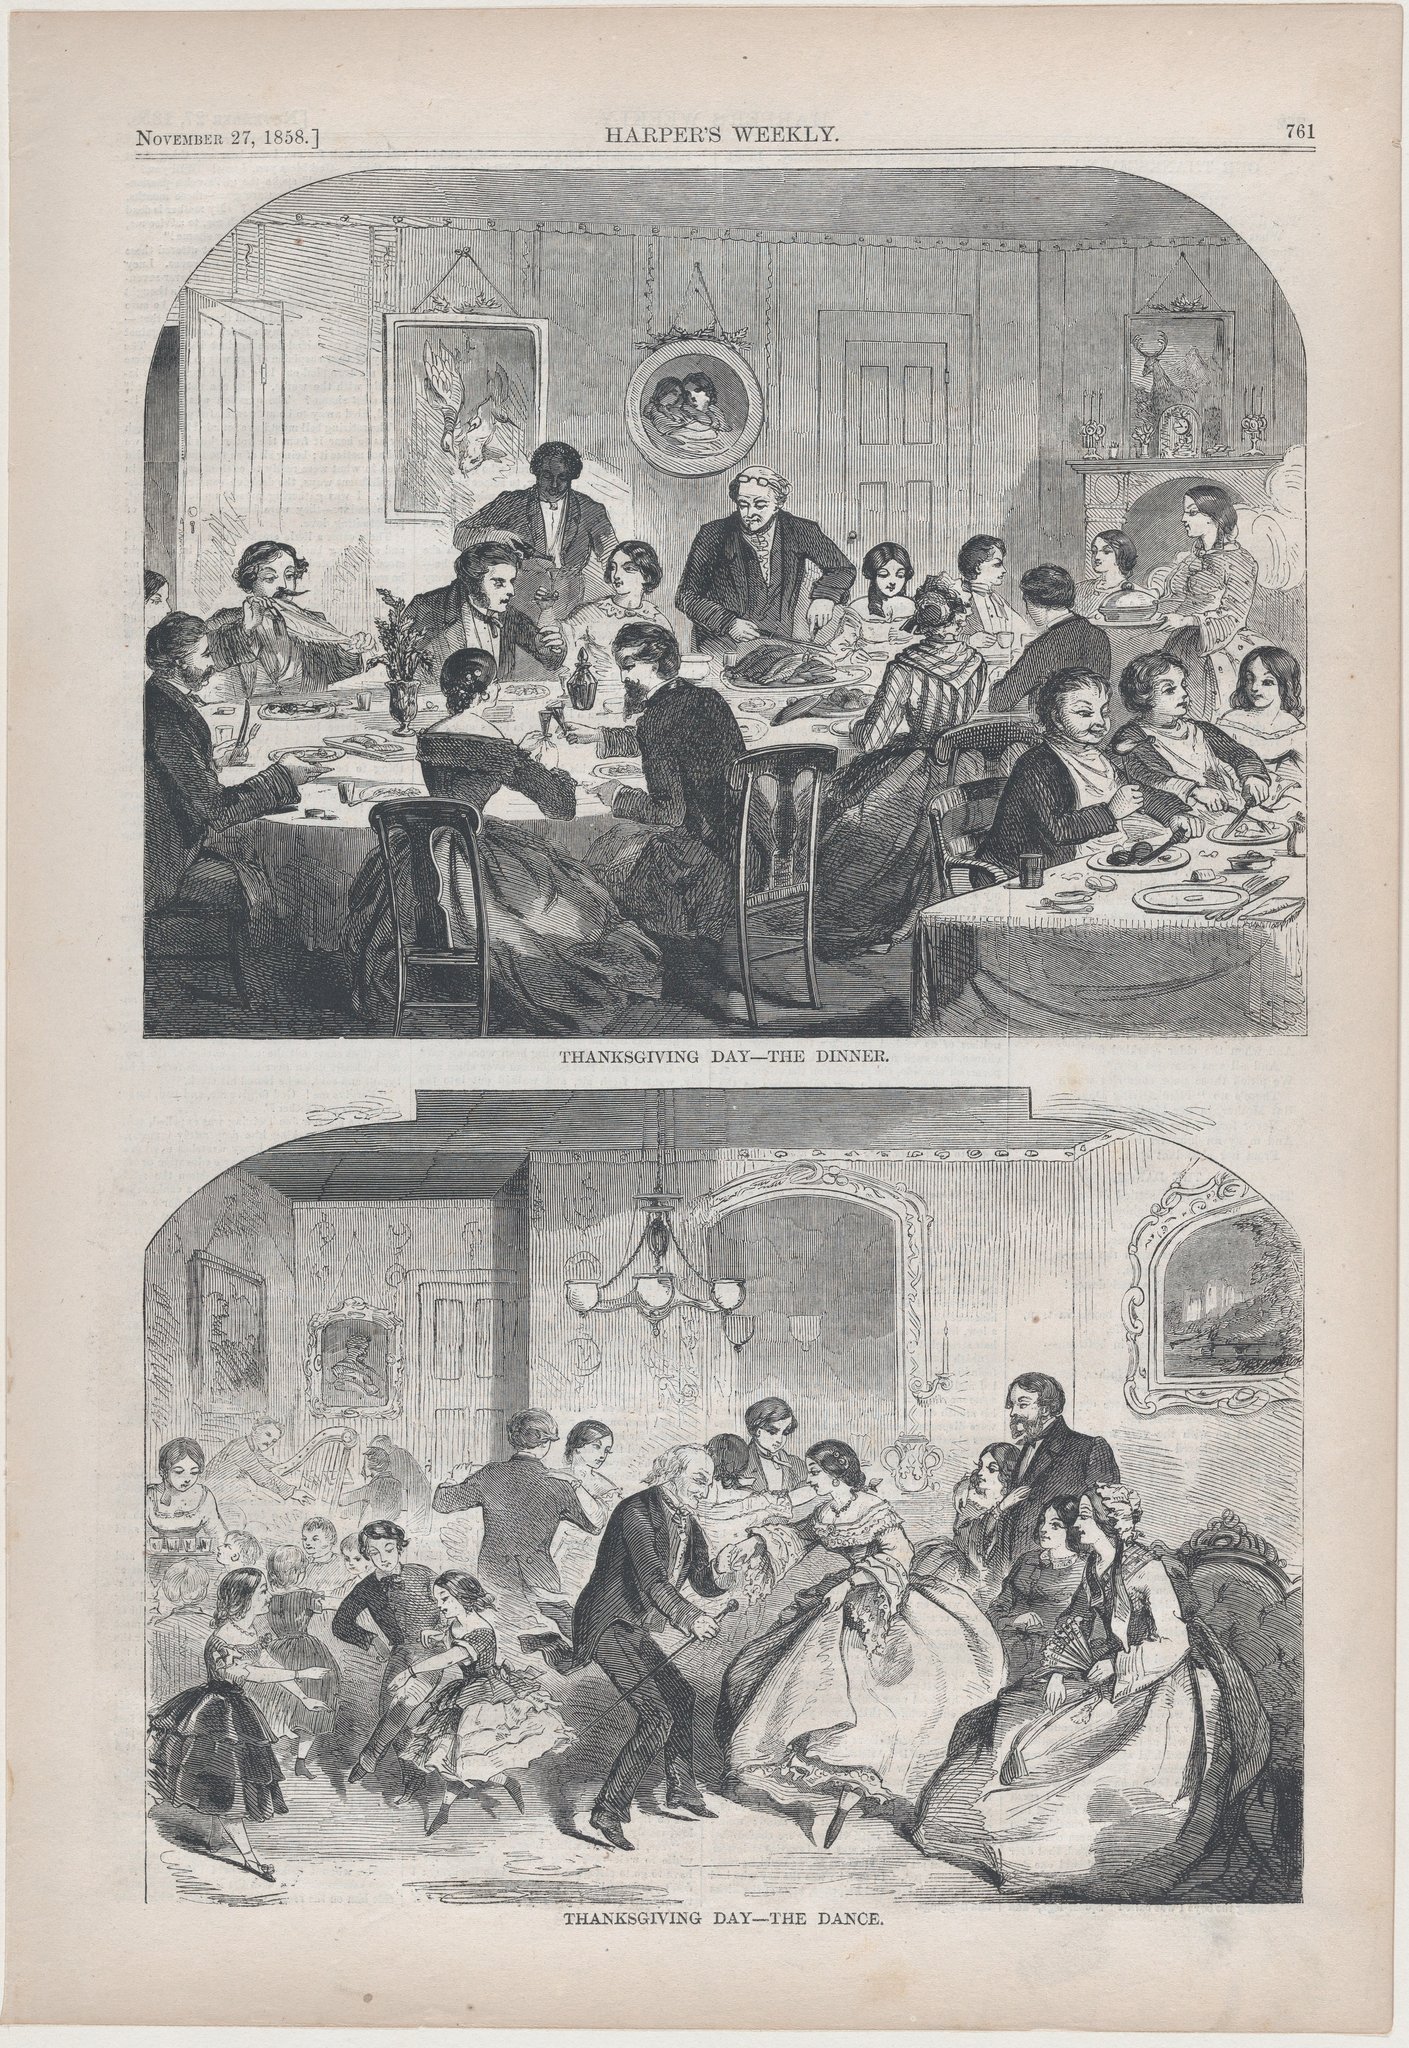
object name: print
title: Thanksgiving Day – The Dance (from "Harper's Weekly," Vol. II)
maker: winslow homer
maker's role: artist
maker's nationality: american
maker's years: 1836-1910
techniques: engraving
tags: men,women,dancing,dining